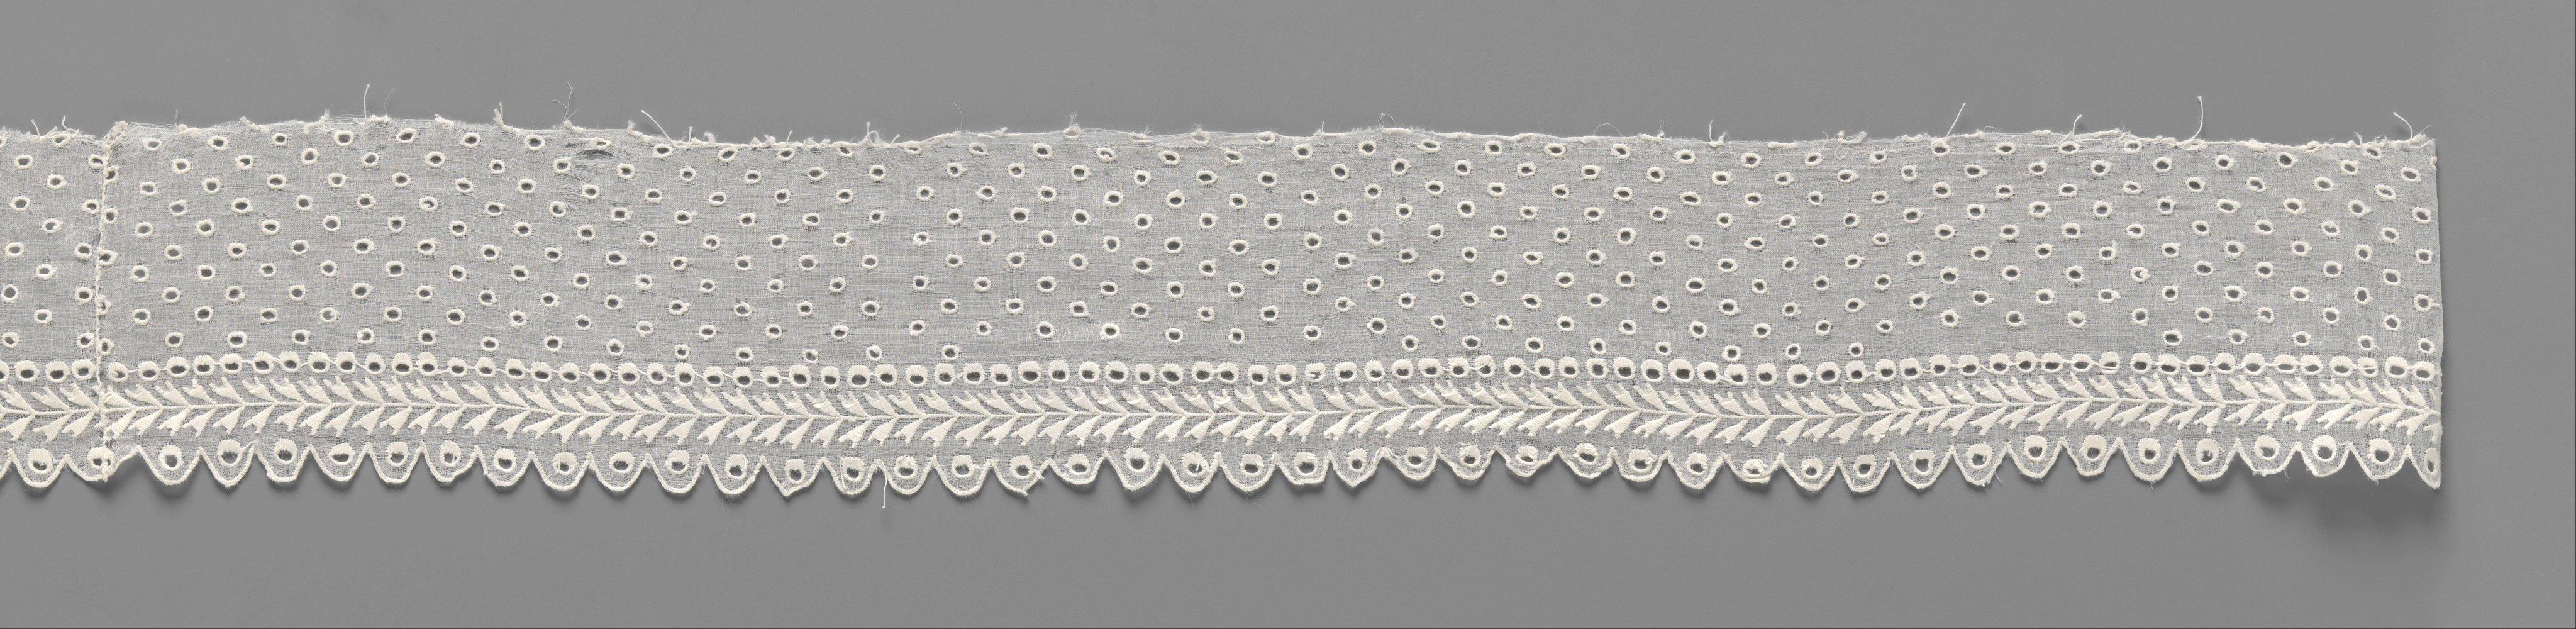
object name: strip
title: Strook van geschulpte neteldoek met wit borduurwerk en ajourwerk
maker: Anonymous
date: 1840-1860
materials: textile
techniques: embroidered, embroidery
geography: switzerland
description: Strook van neteldoek met borduurwerk. De strook heeft een flauw geschulpte rand, waarlangs sterbloemen lopen en een opengewerkt lint, dat opgenomen wordt met grote wingerdbladeren. Het patroon heeft verder rijen sterbloemen.